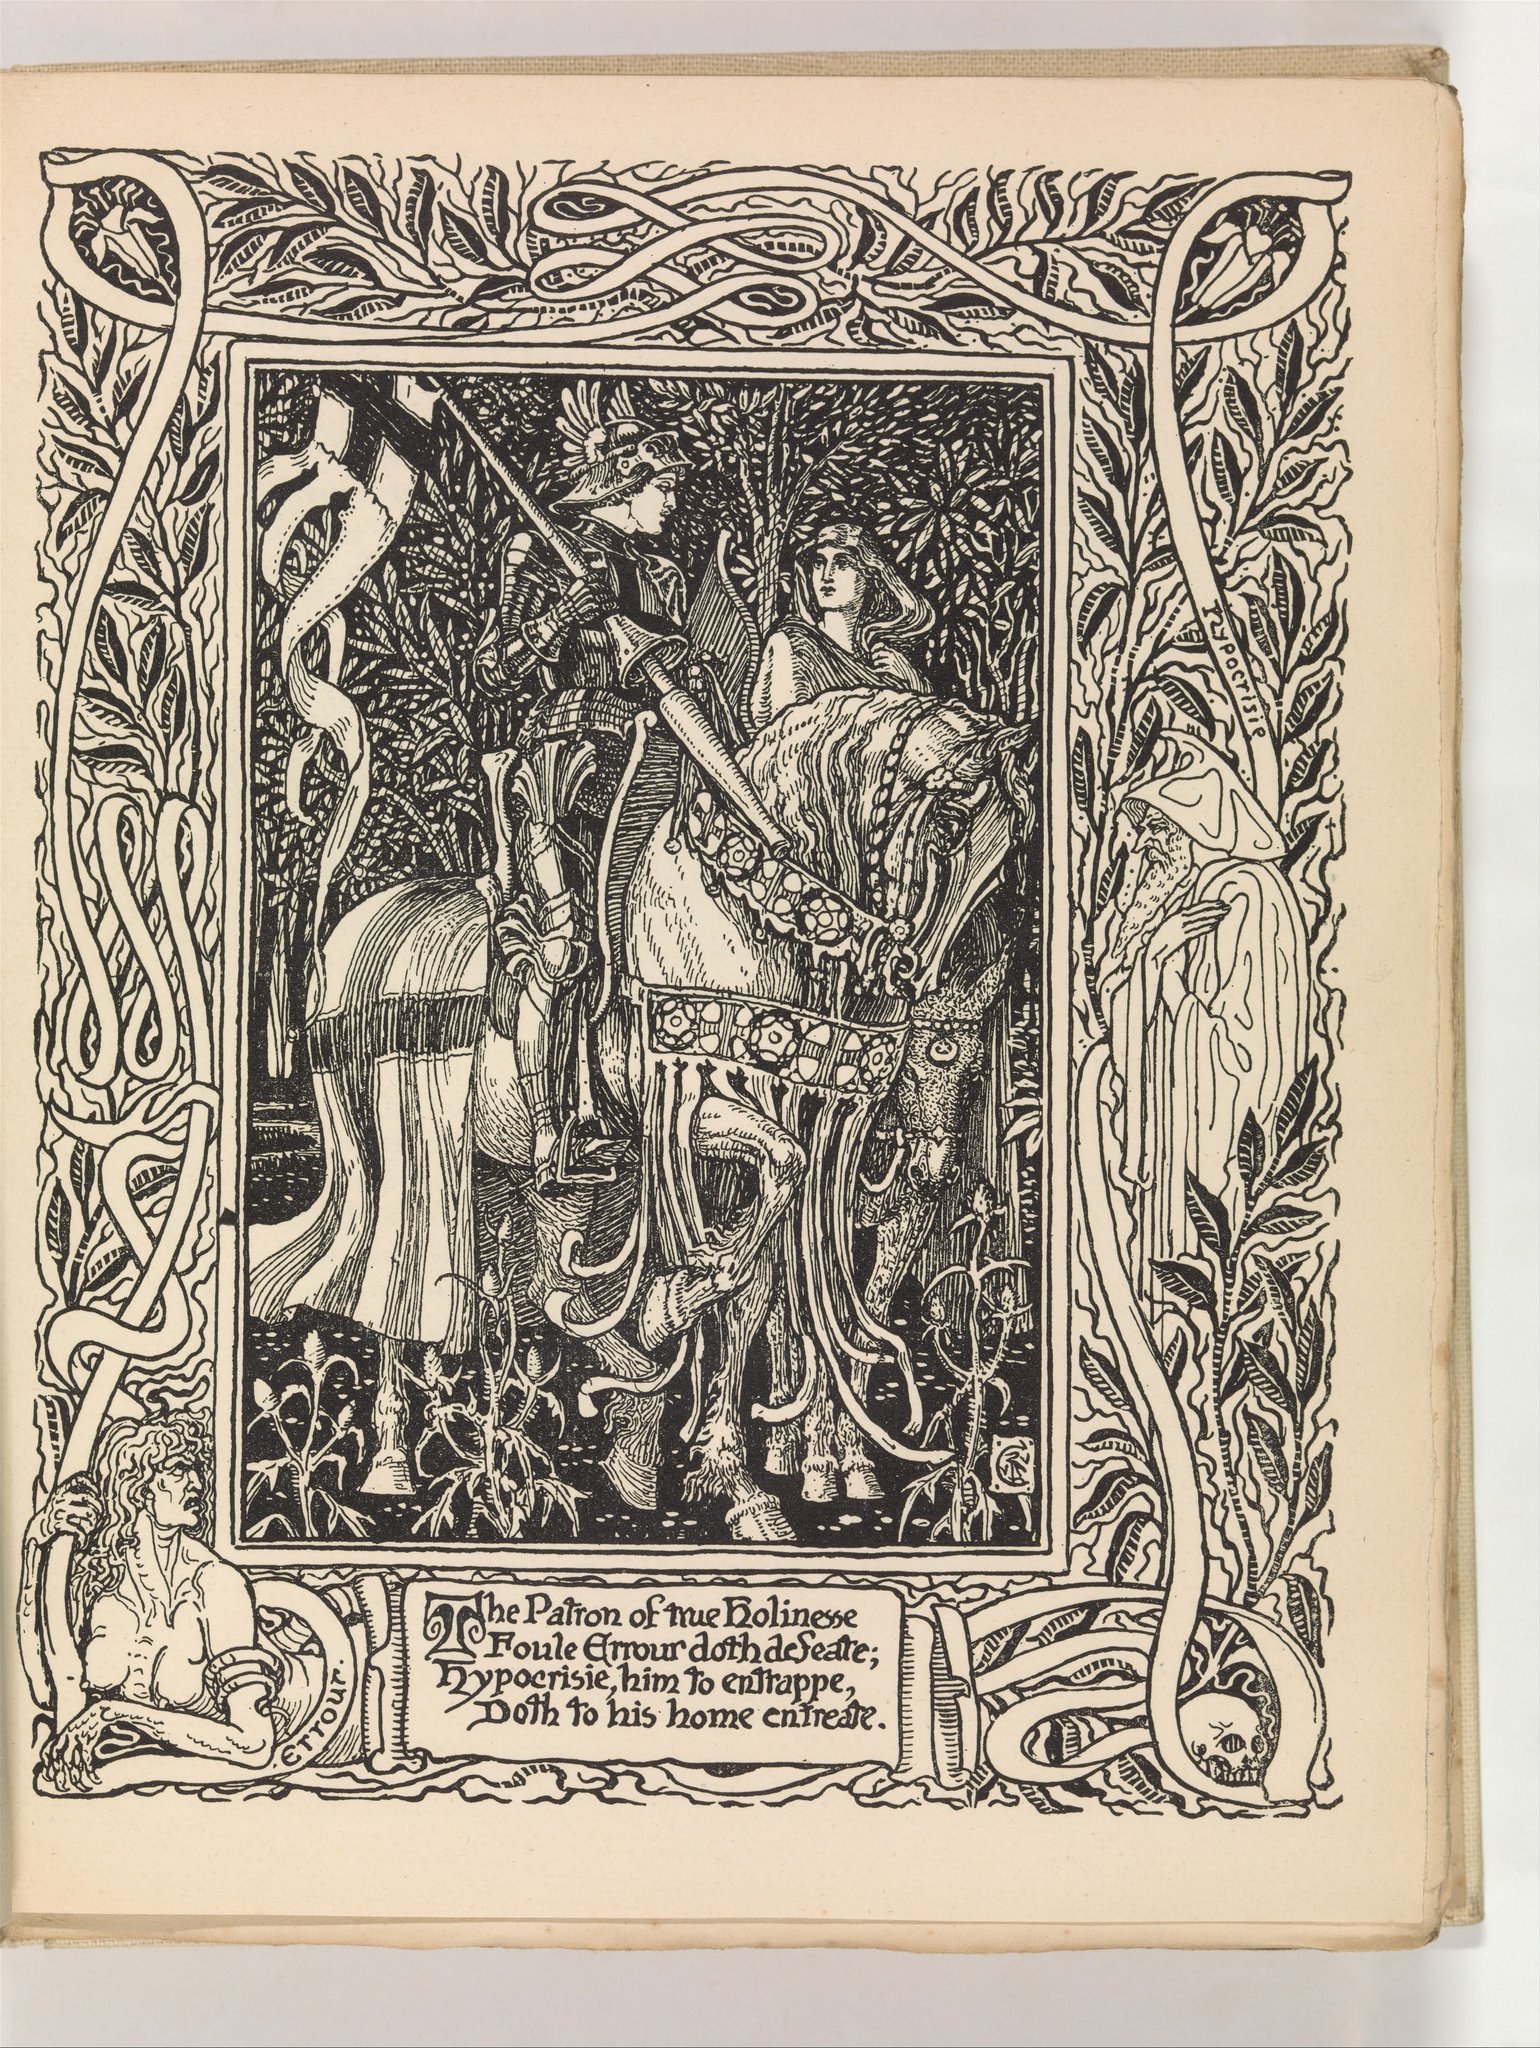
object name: book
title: The Faerie Queene, A Poem in Six Books with the Fragment Mutabilitie: Book I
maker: edmund spenser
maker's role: author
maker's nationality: british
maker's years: 1552-1599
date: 1894-1897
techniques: woodcut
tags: men,women,horses,leaves,flags